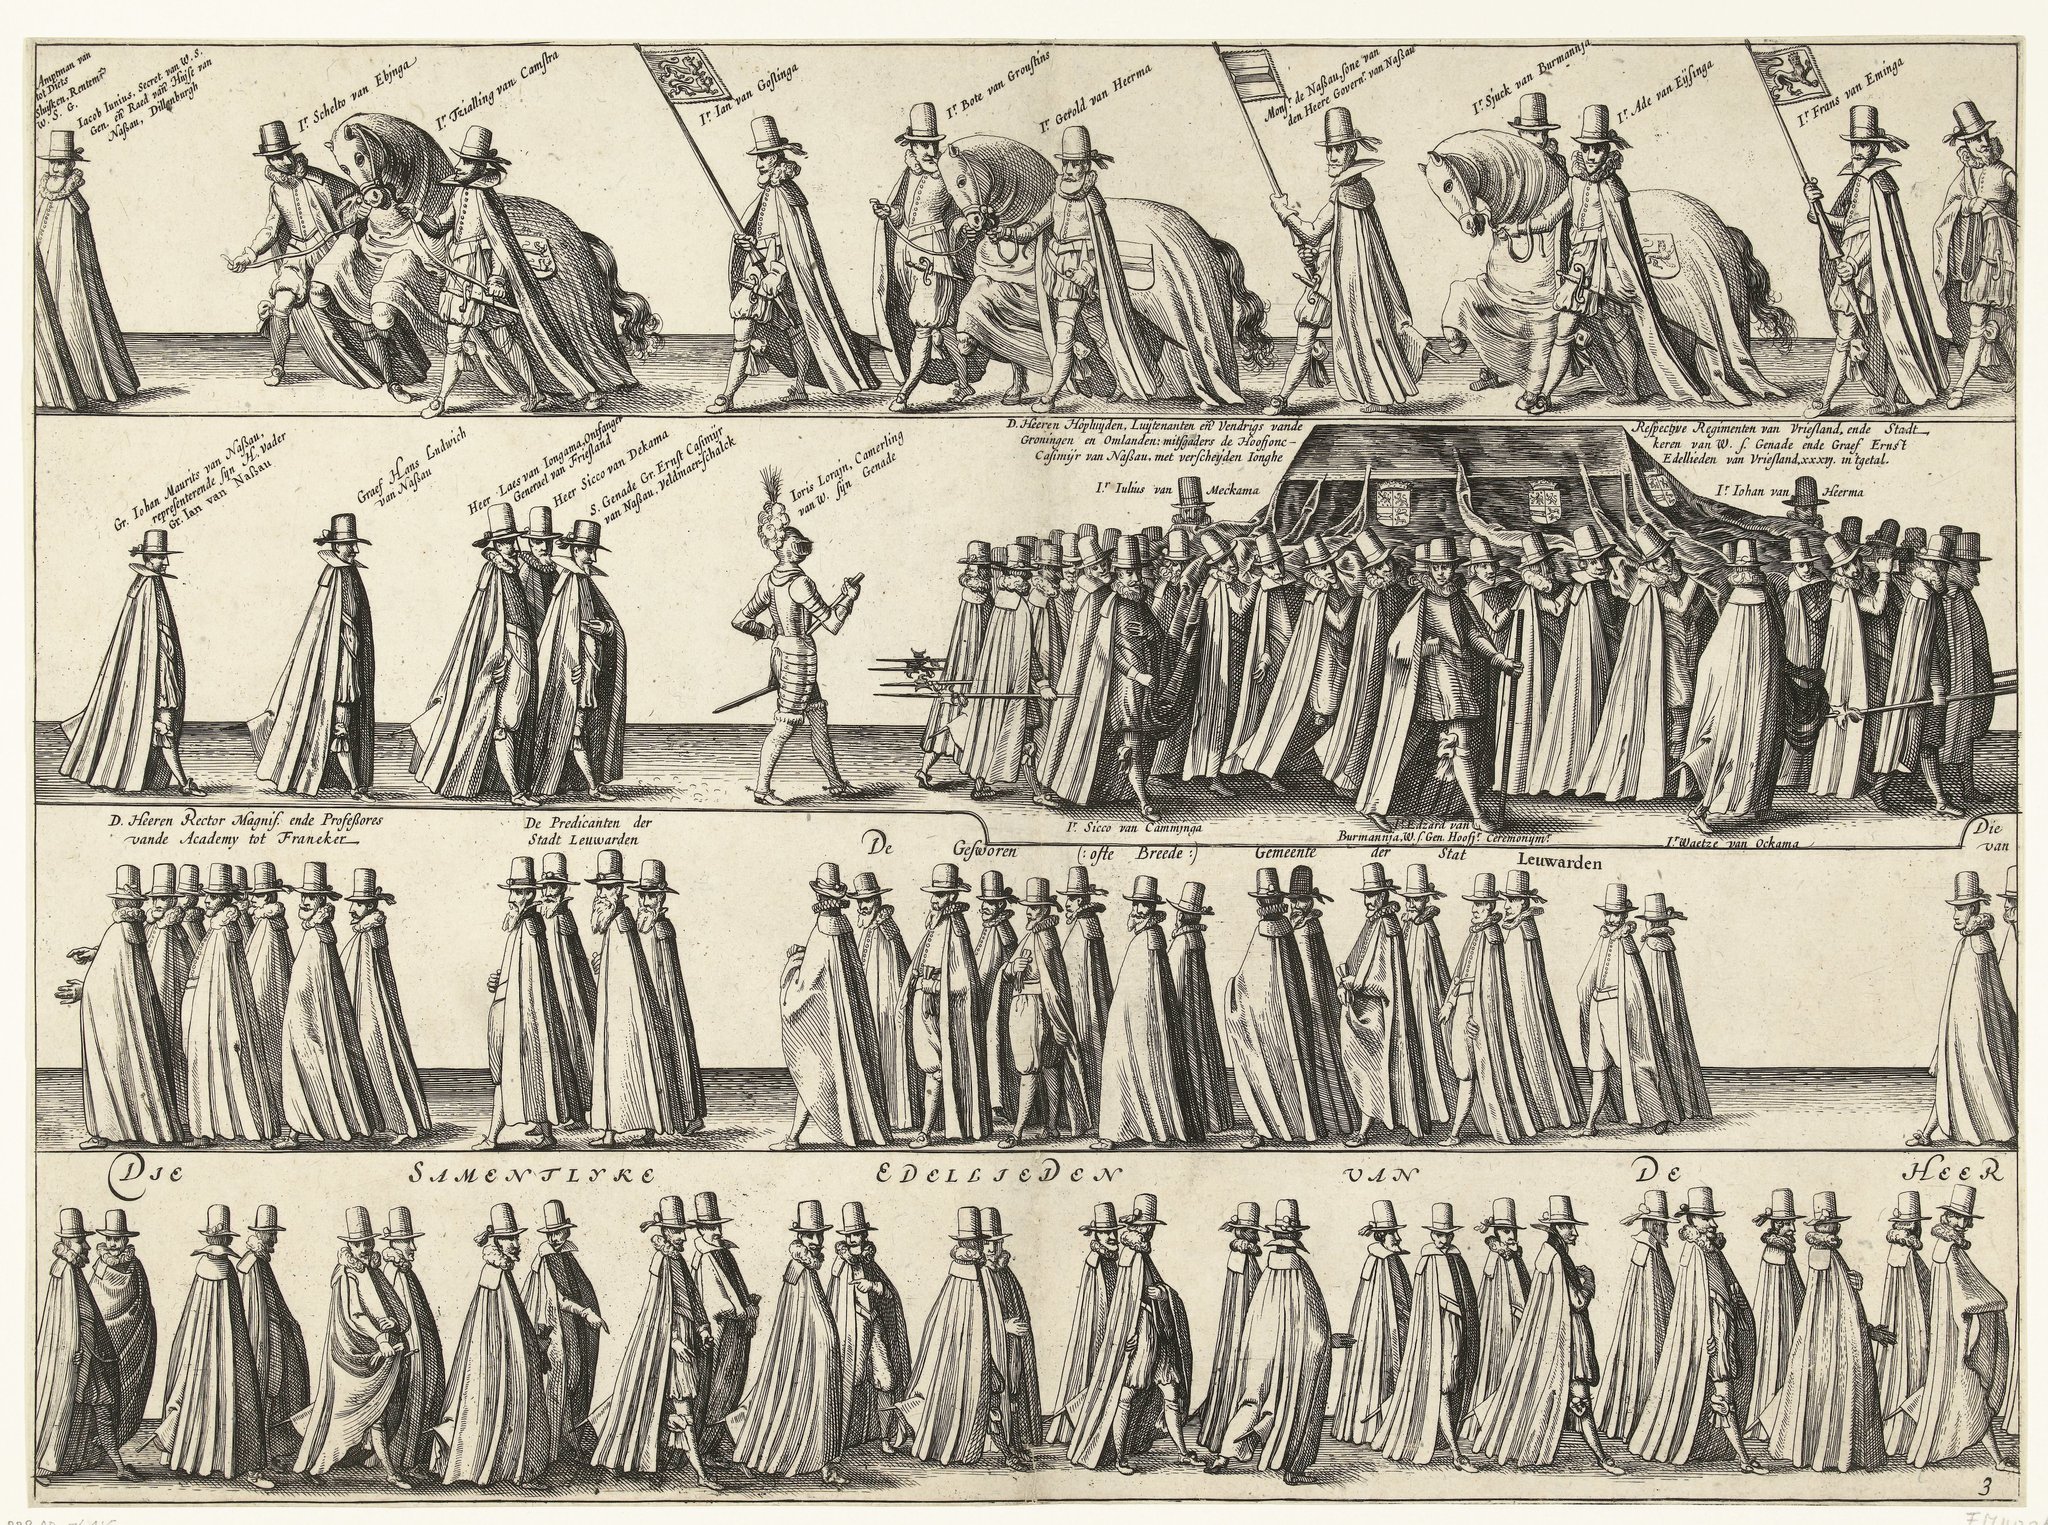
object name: print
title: Begrafenis van Willem Lodewijk, graaf van Nassau, in de Grote Kerk te Leeuwarden, 1620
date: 1620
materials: paper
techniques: etching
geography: northern netherlands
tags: earl, johan maurits graaf van nassau-siegen, willem lodewijk graaf van nassau-dillenburg, ernst casimir graaf van nassau-dietz, cortege, funeral procession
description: Begrafenis van Willem Lodewijk, graaf van Nassau, in de Grote Kerk te Leeuwarden op 13 juli 1620, blad 3. Blad met de kist, paarden, graaf Ernst Casimir, graaf Johan Maurits en andere deelnemers aan de begrafenisstoet, met naam.